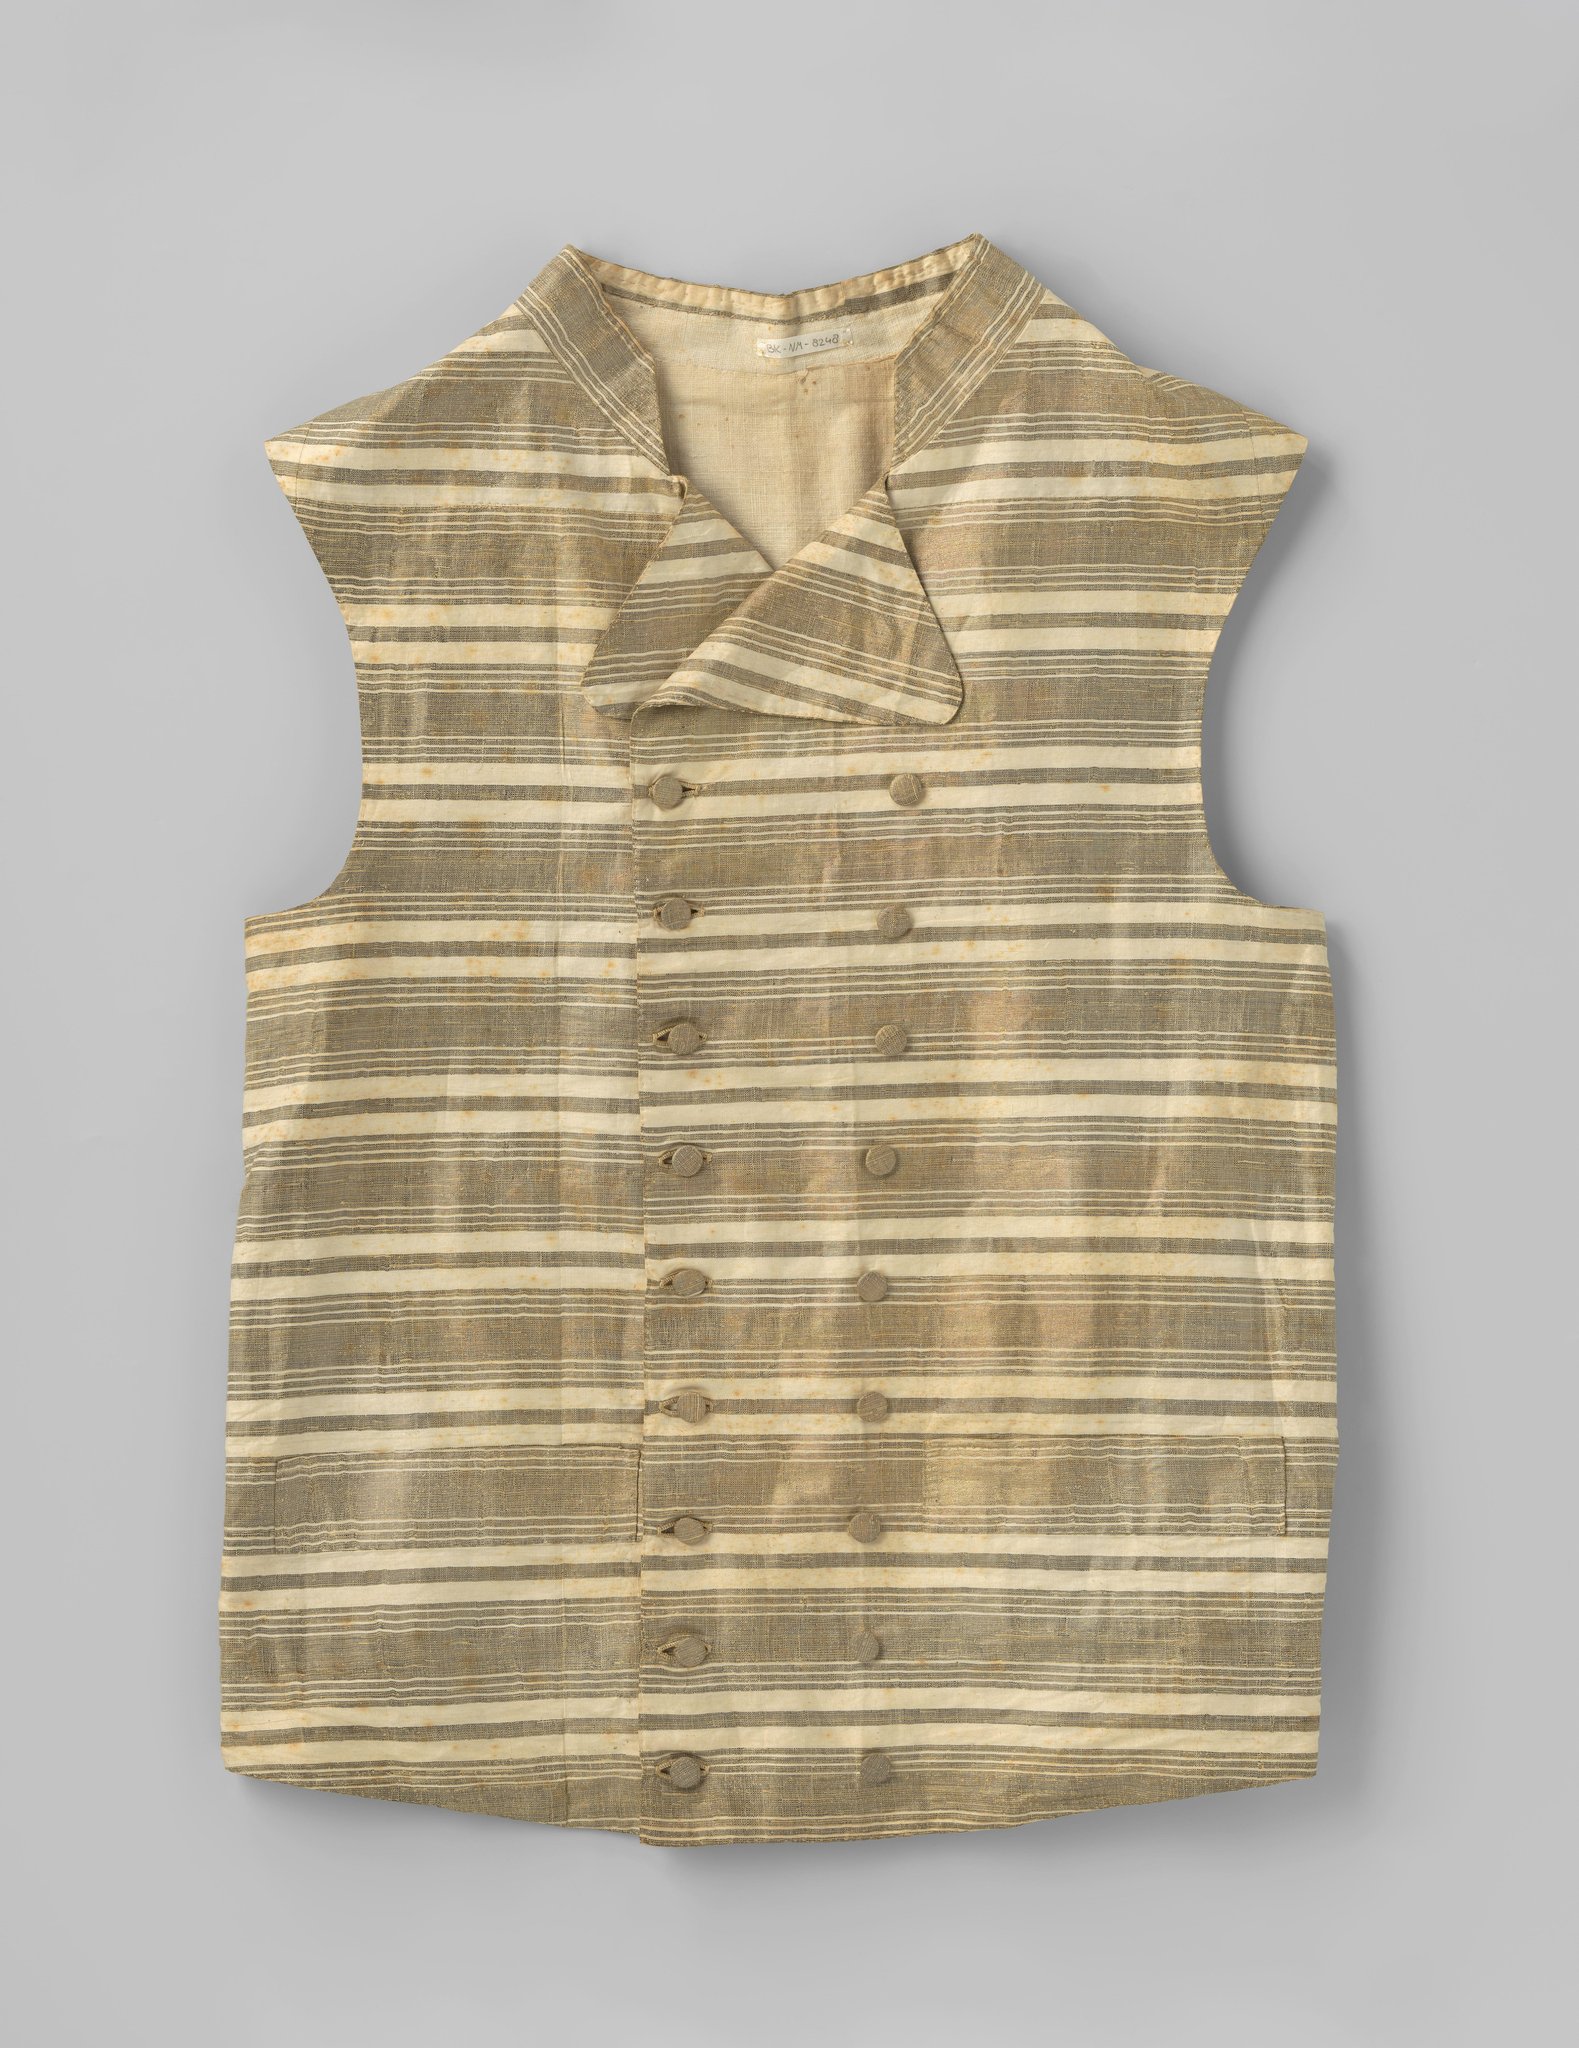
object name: menswear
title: Vest met staande kraag, revers en tweemaal negen stofknopen van smal en breed gestreept wit katoen en goudbrokaat; voering van crème linnen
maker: Anonymous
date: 1790-1800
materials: cotton, linen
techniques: brocade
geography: europe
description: Vest van katoen met daarin geweven gouden strepen.